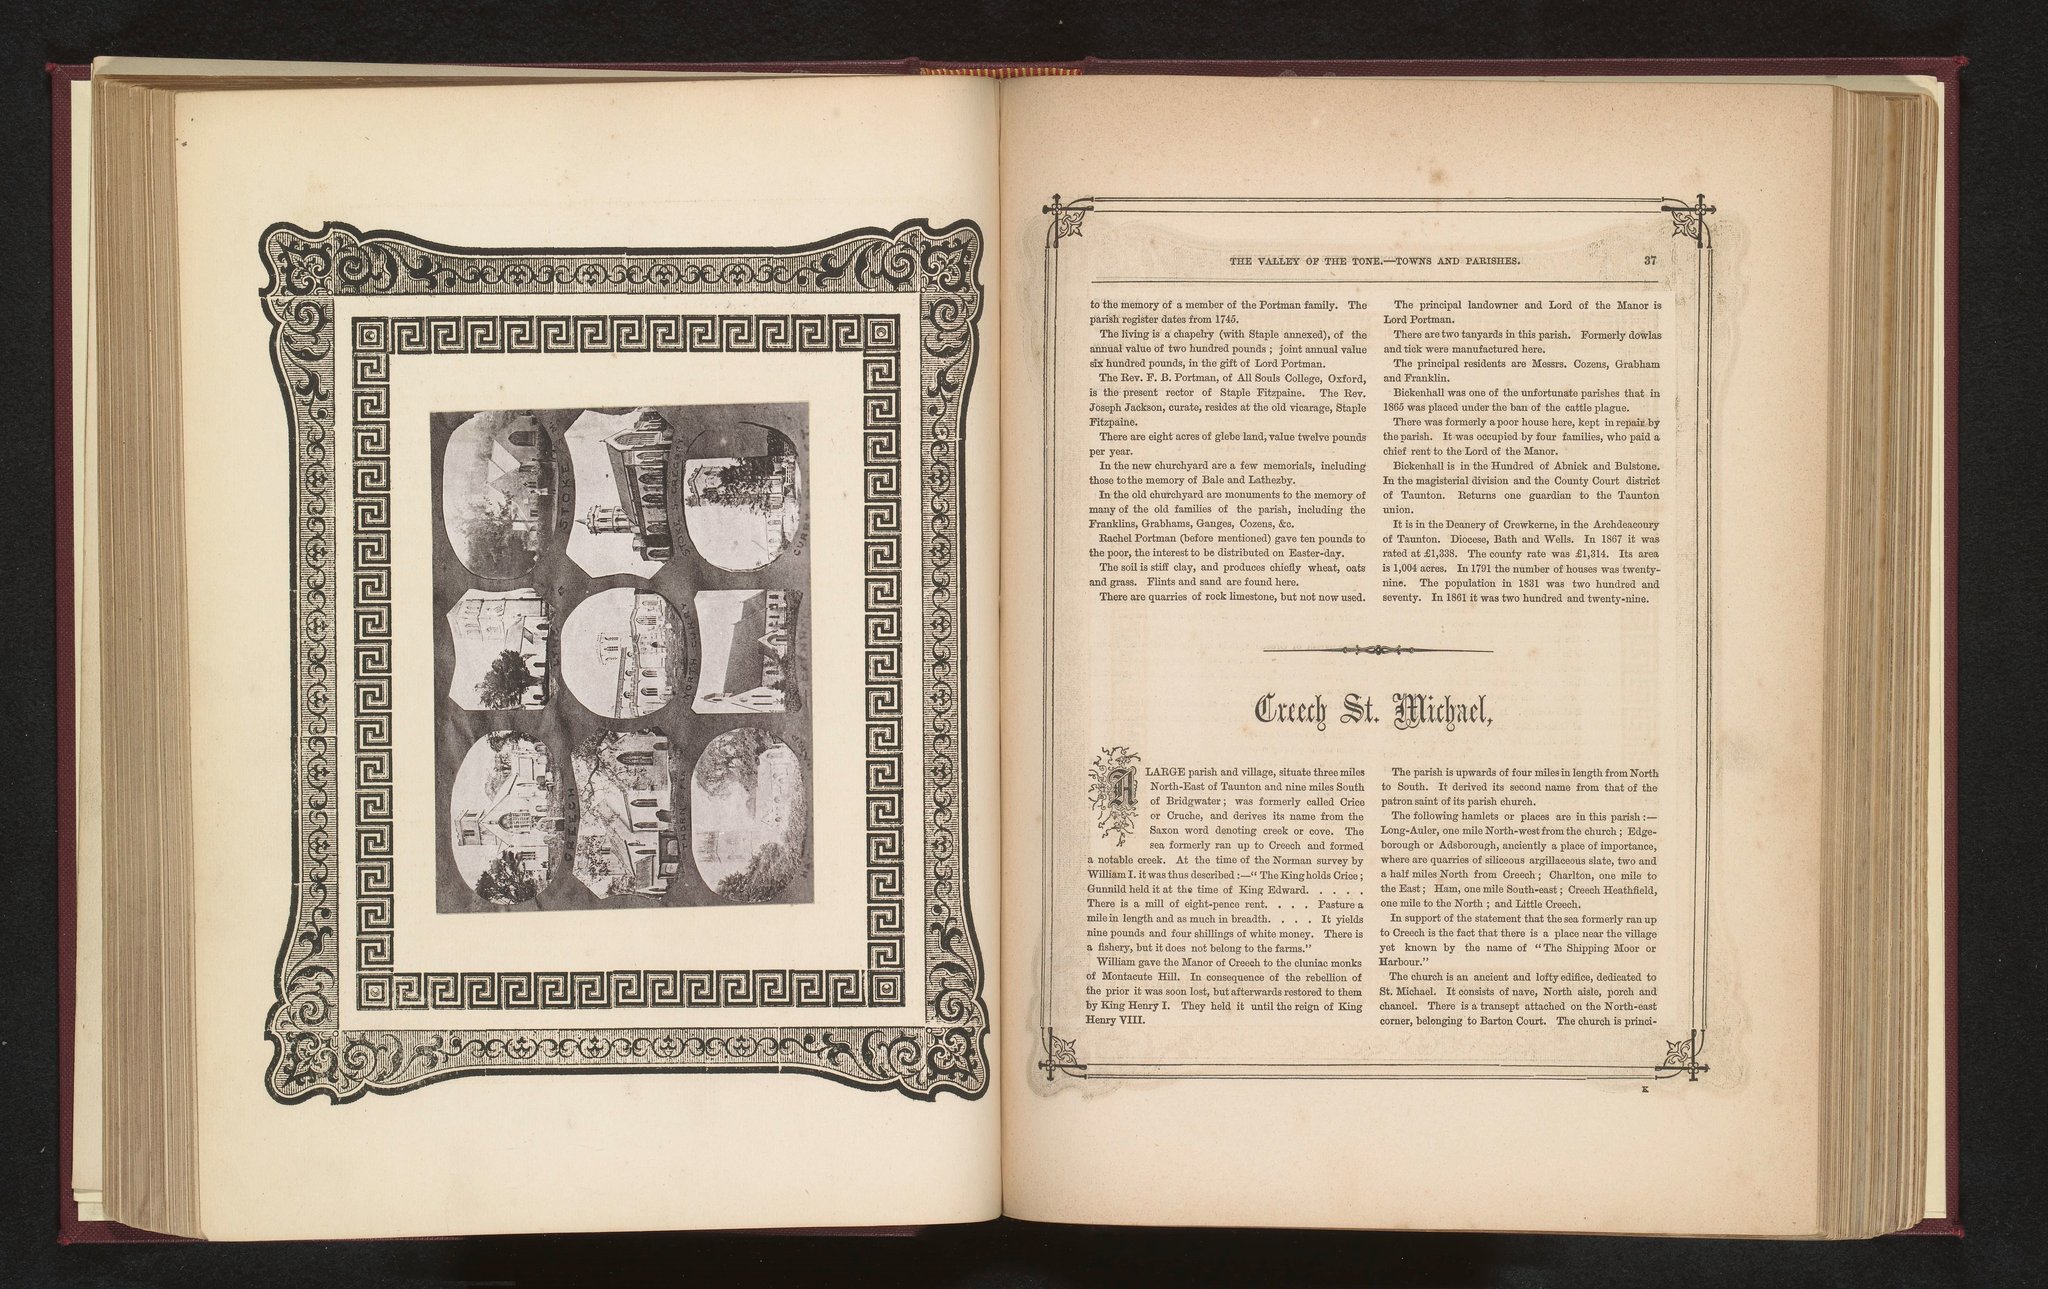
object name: photomontage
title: Negen gezichten op kerken in West Dorset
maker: Anonymous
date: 1868-1873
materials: paper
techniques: photoaquatint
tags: church (exterior)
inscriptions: inscription: ‘Creech (...) Cur[...]’